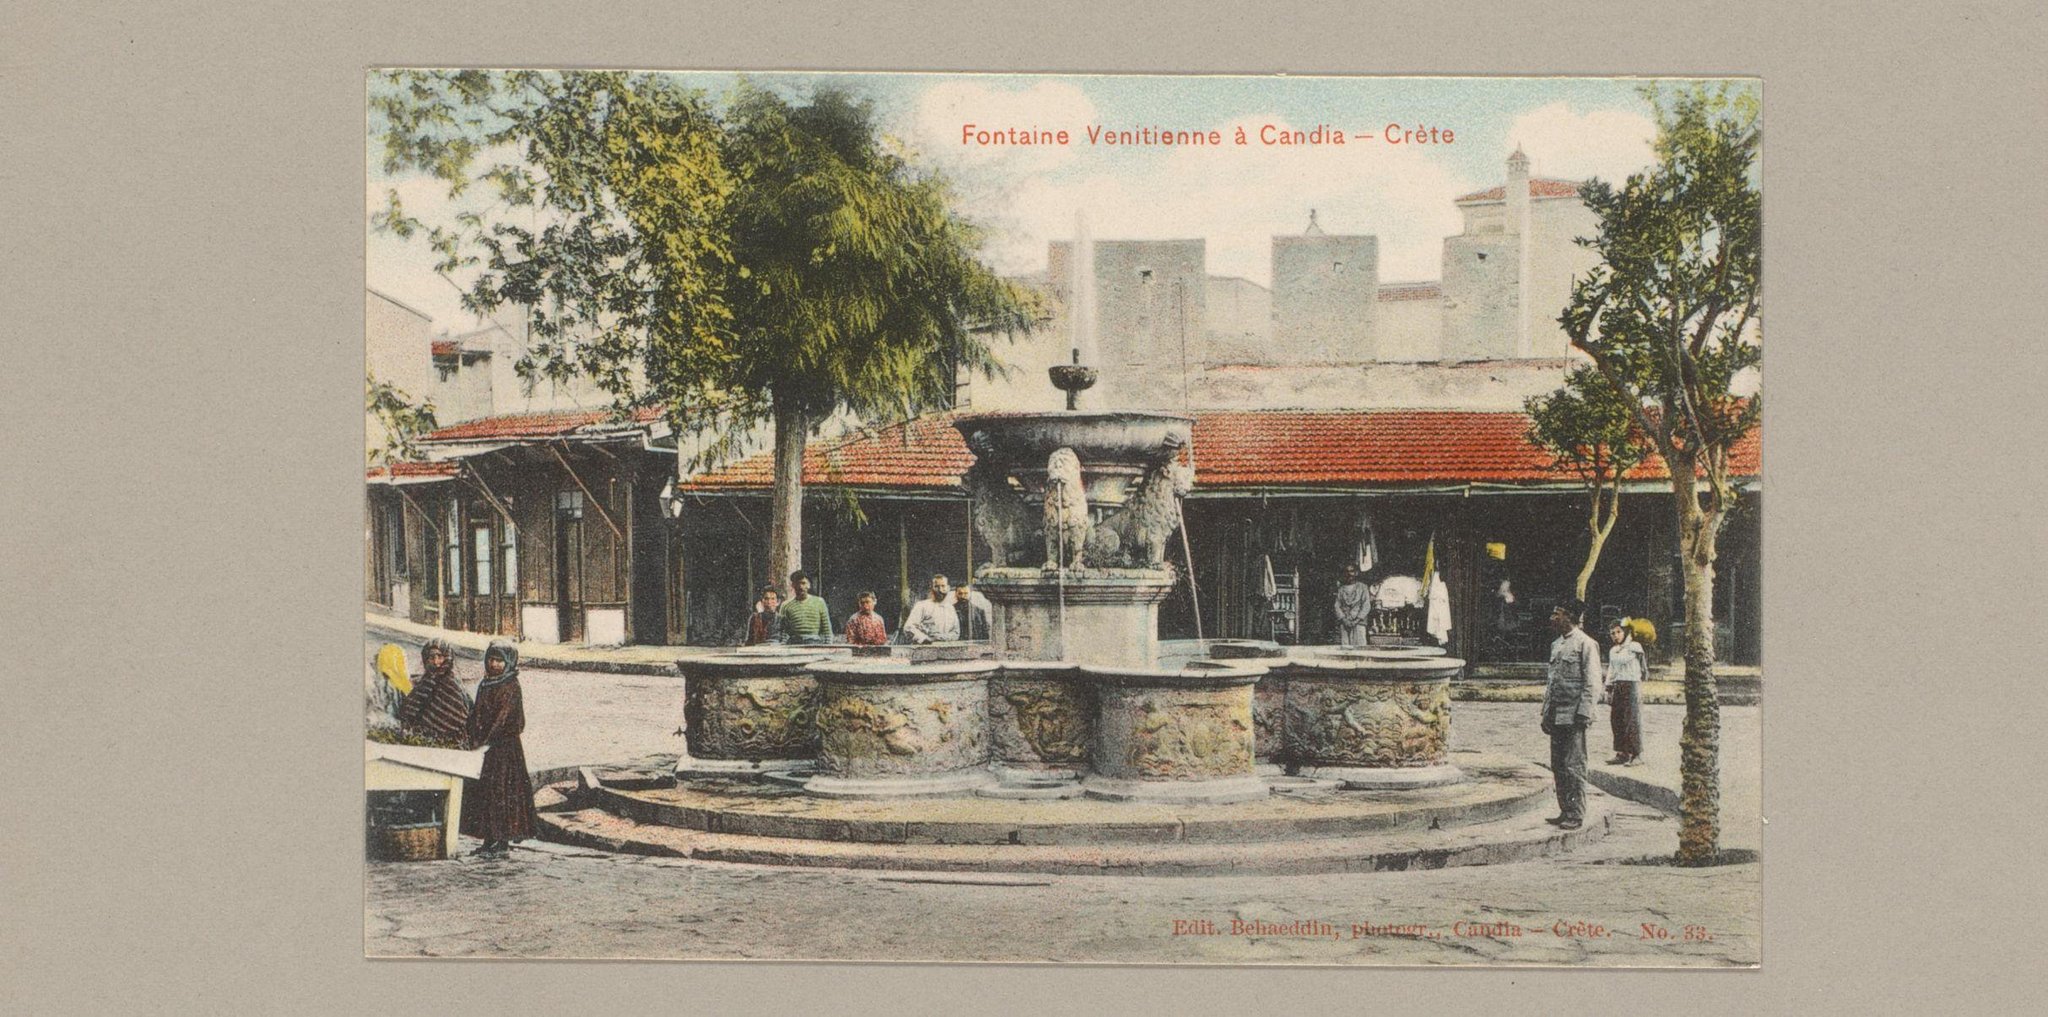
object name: photograph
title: Fontaine Venitienne à Candia - Crète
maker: bediz behaeddin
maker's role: fotograaf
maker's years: 1875-1951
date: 1895-1915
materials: cardboard, paper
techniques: photograph, lithograph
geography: creta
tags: kreta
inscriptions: number: ‘64.’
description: Rechtsonder staat: Edit. Behaeddin, photogr., Candia - Crète. No. 33.